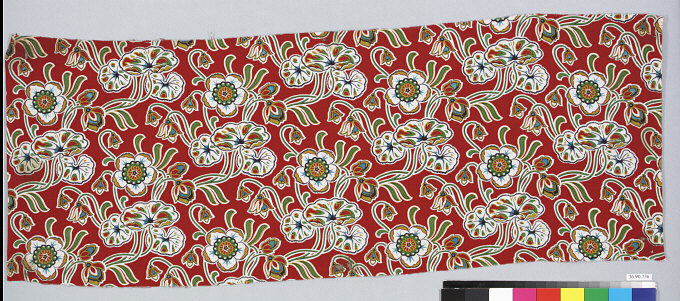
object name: piece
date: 1867-1900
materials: cotton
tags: flowers,leaves